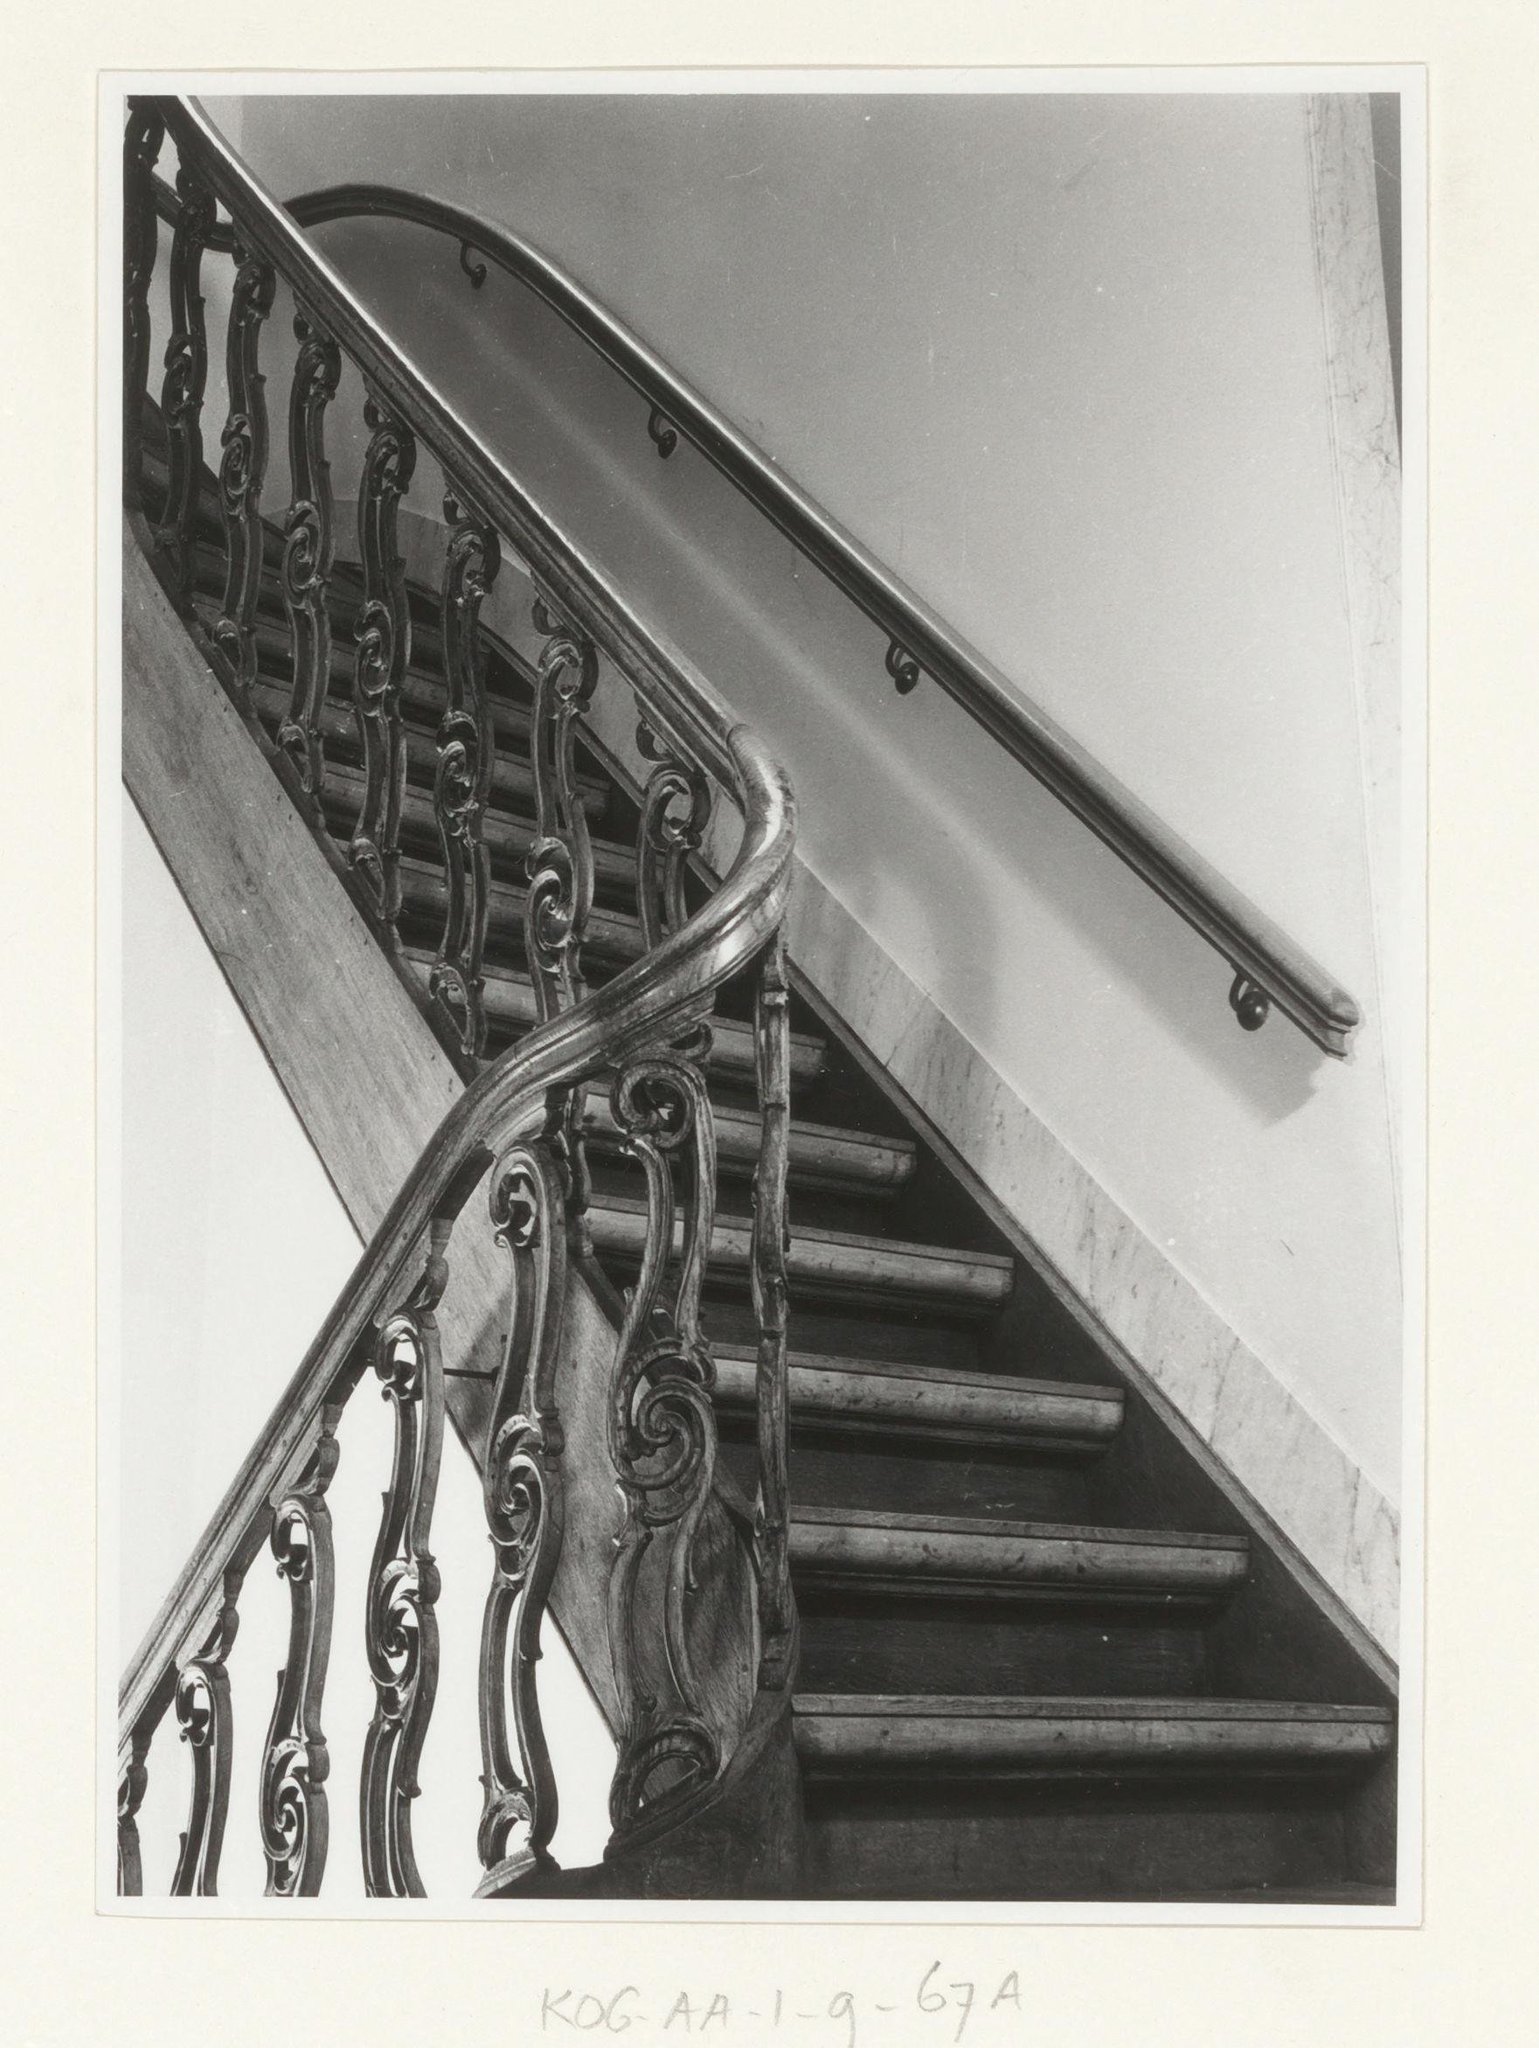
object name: photograph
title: Trappenhuis van Keizersgracht 567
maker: Anonymous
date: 1880-1950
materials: paper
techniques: gelatin silver print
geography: amsterdam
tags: staircase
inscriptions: inscription: ‘Keizersgracht 567 / trap. 18e eeuws’, inscription: ‘Keizersgracht 567’, collector's mark: ‘9.67AB’ Lugt 1641b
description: Onderwerpsrubriek binnen de Atlas Amsterdam: Kadijksplein, Karthuizerkerkhof, Kattegat, Kattenburg, Kapelsteeg O.Z., Enge Kerksteeg, Kerkstraat, Kinkerstraat, Kolk O.Z., Koningsplein, Kromboomsloot [Krom Boomssloot], Kostverlorenkade, Kwakersdwarspad, Kalverstraat, Keizersgracht (v.d. Brouwersgracht – Amstel), Klerensloot (Gedempte), Klimopstraat, Kloveniersburgwal, Kraansluis.